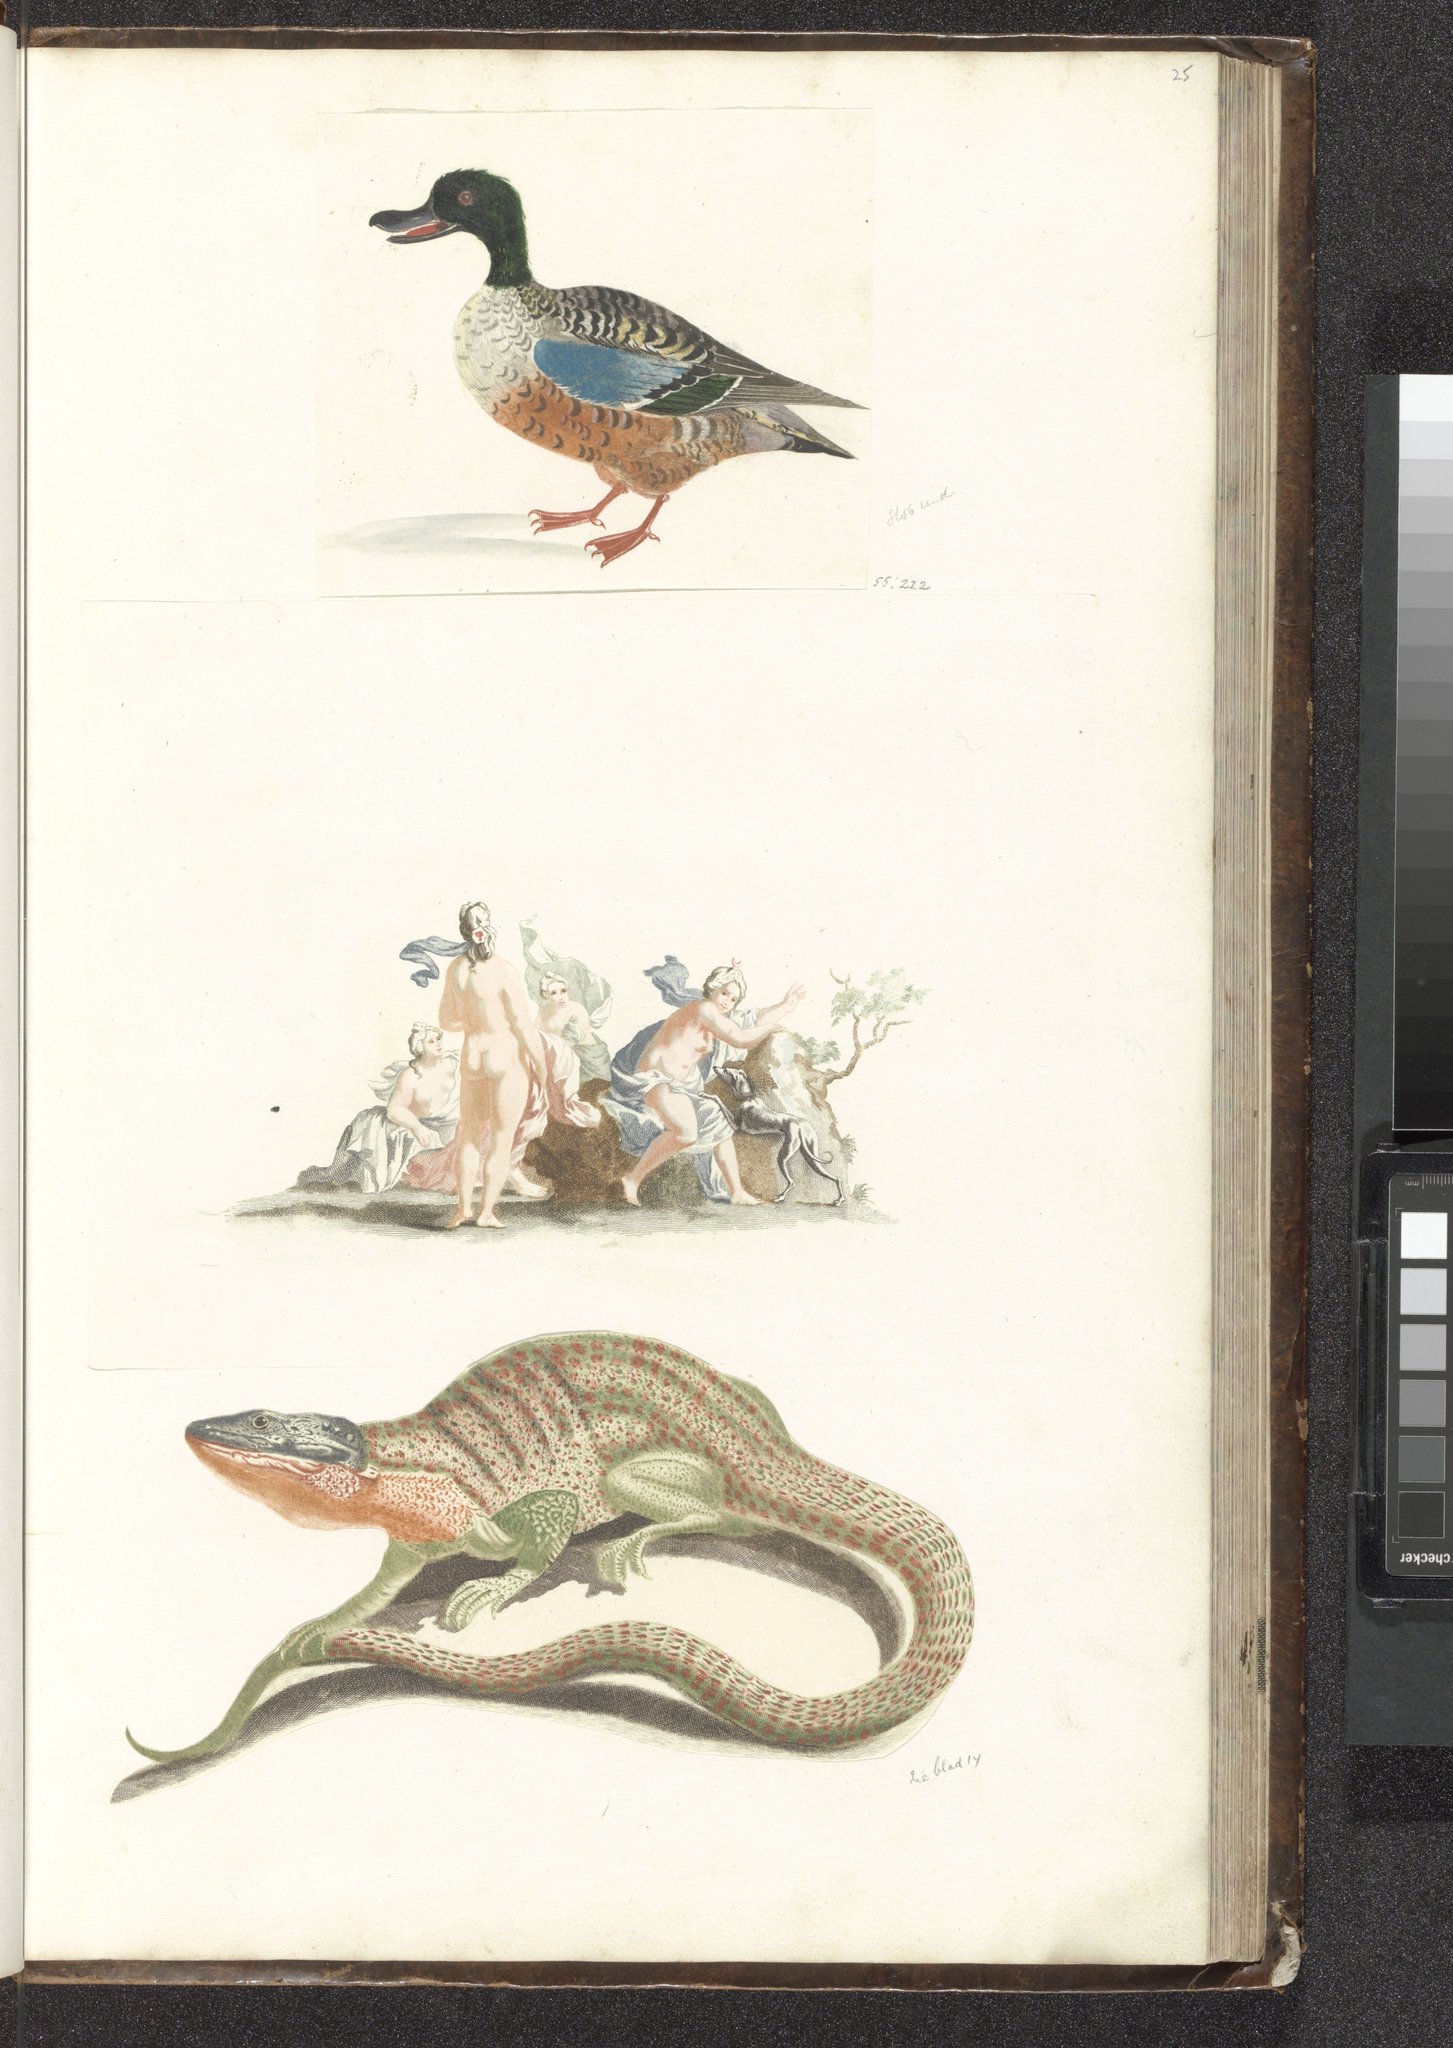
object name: album leaf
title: Staande eend naar links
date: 1688-1698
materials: paper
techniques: printing, engraving, hand coloring, lithography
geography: netherlands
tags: water-birds: duck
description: Deze prent maakt deel uit van een album.